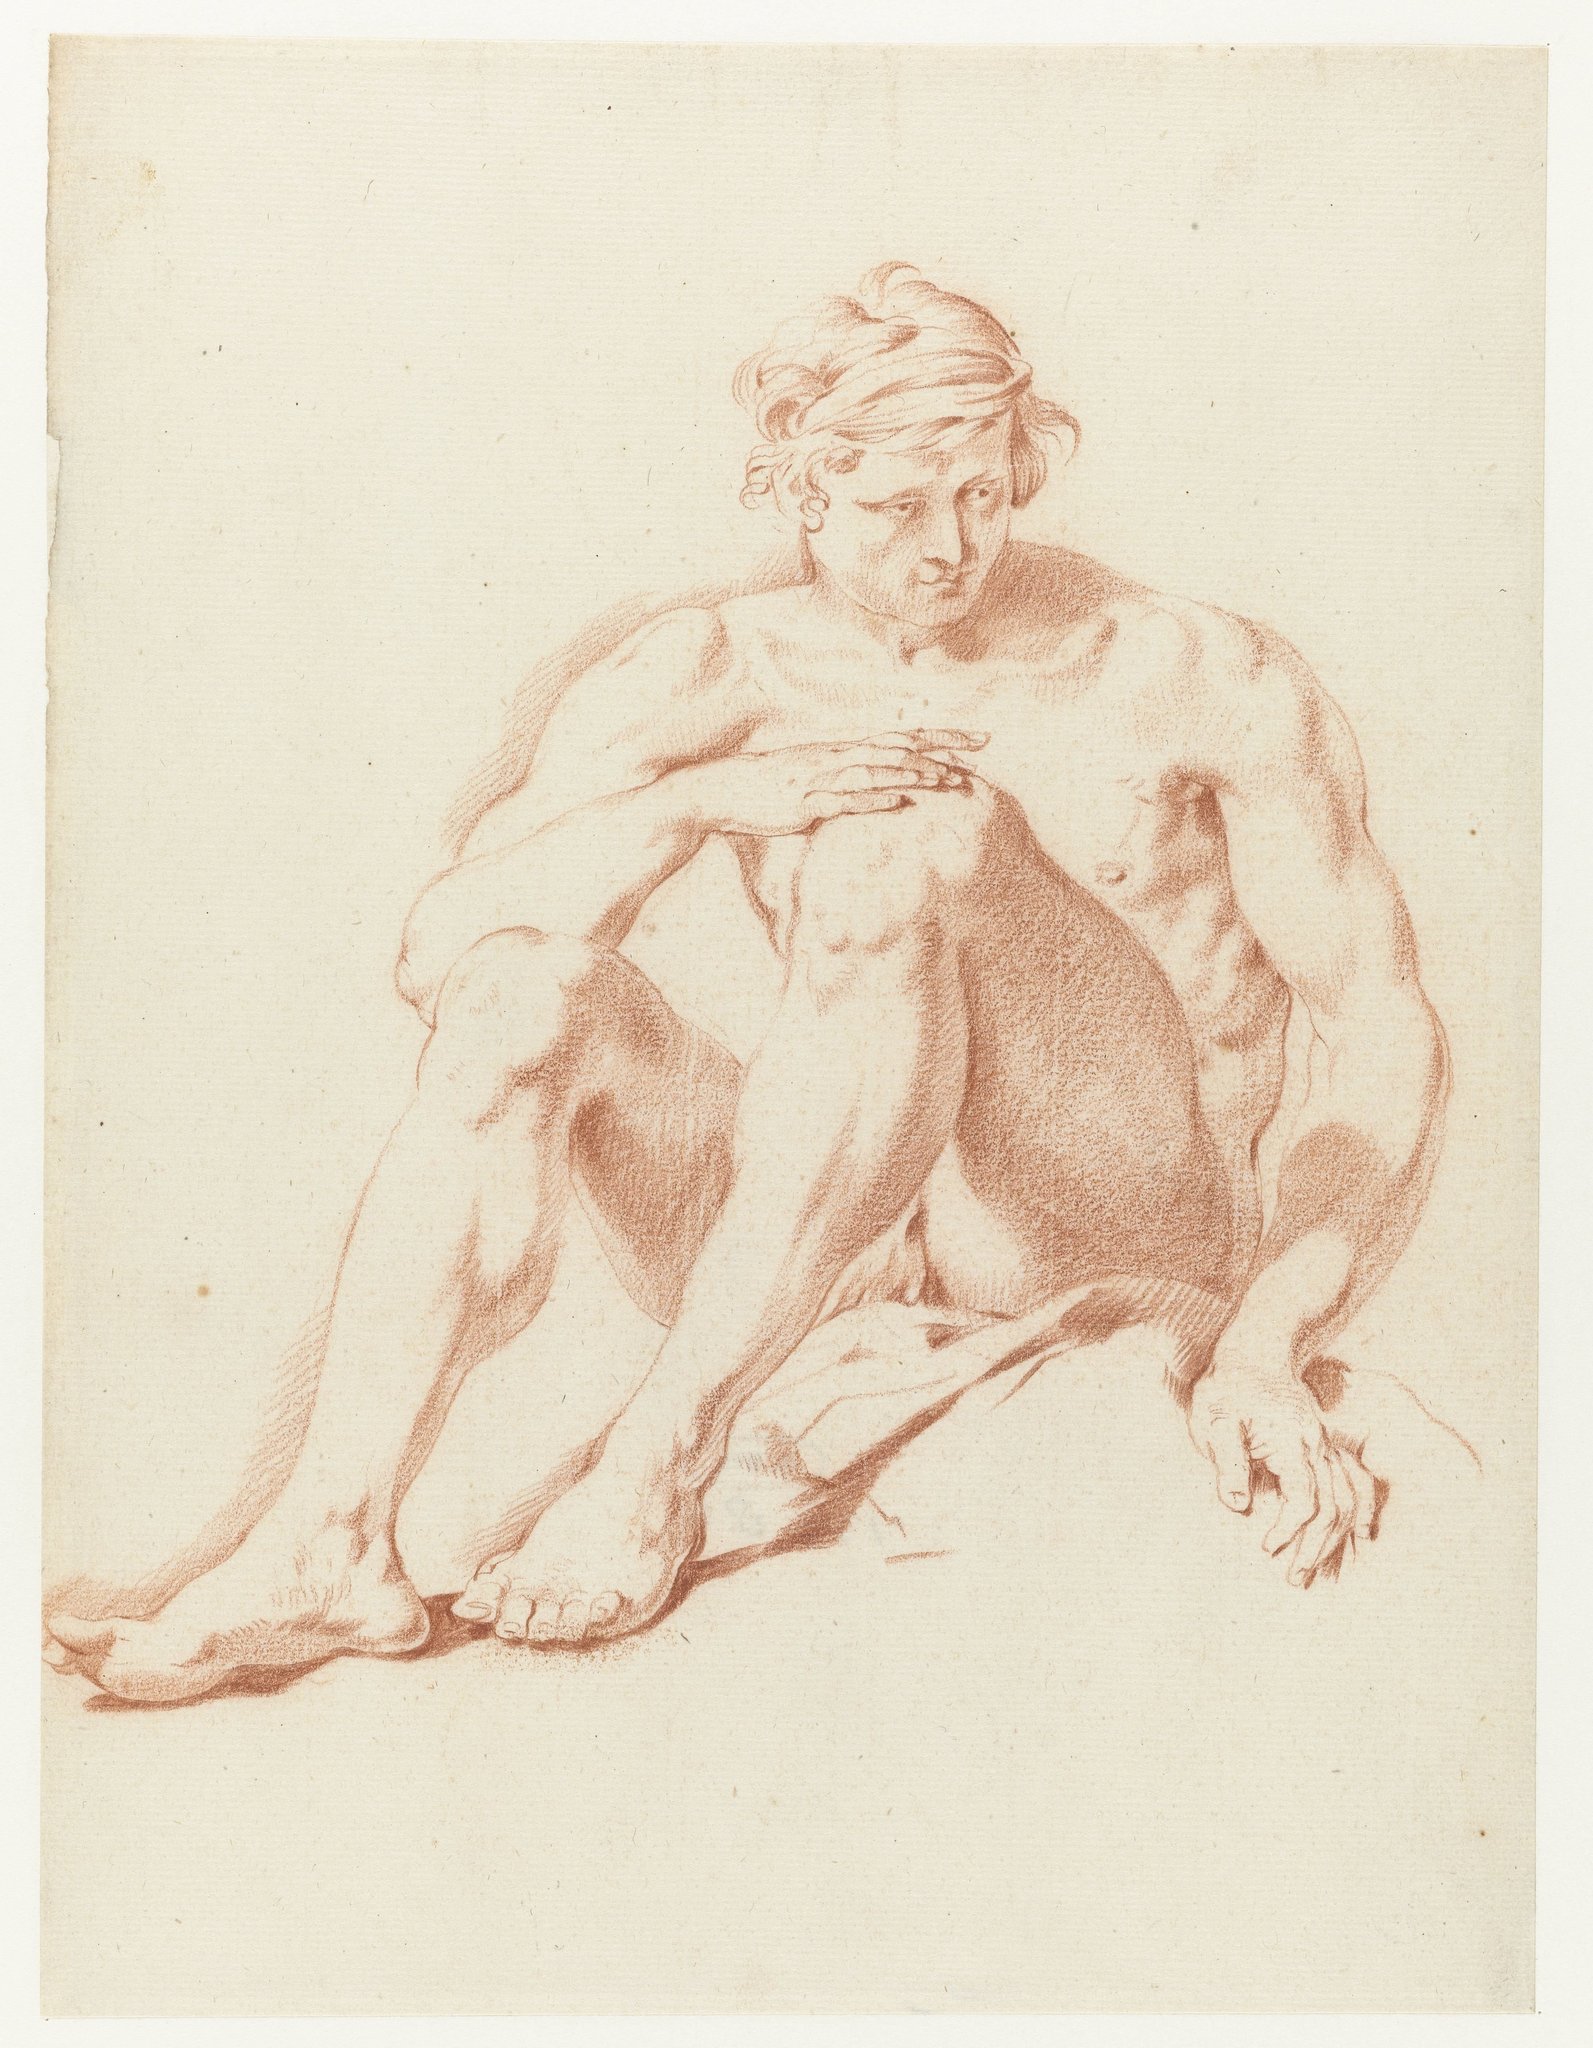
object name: drawing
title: Zittend mannelijk naakt, met opgetrokken benen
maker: jan hoogsaat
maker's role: painter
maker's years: 1654-1750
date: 1664-1730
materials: chalk, paper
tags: human figure of ideal proportions, e.g. academic nude, sitting with arms or elbows on the knees